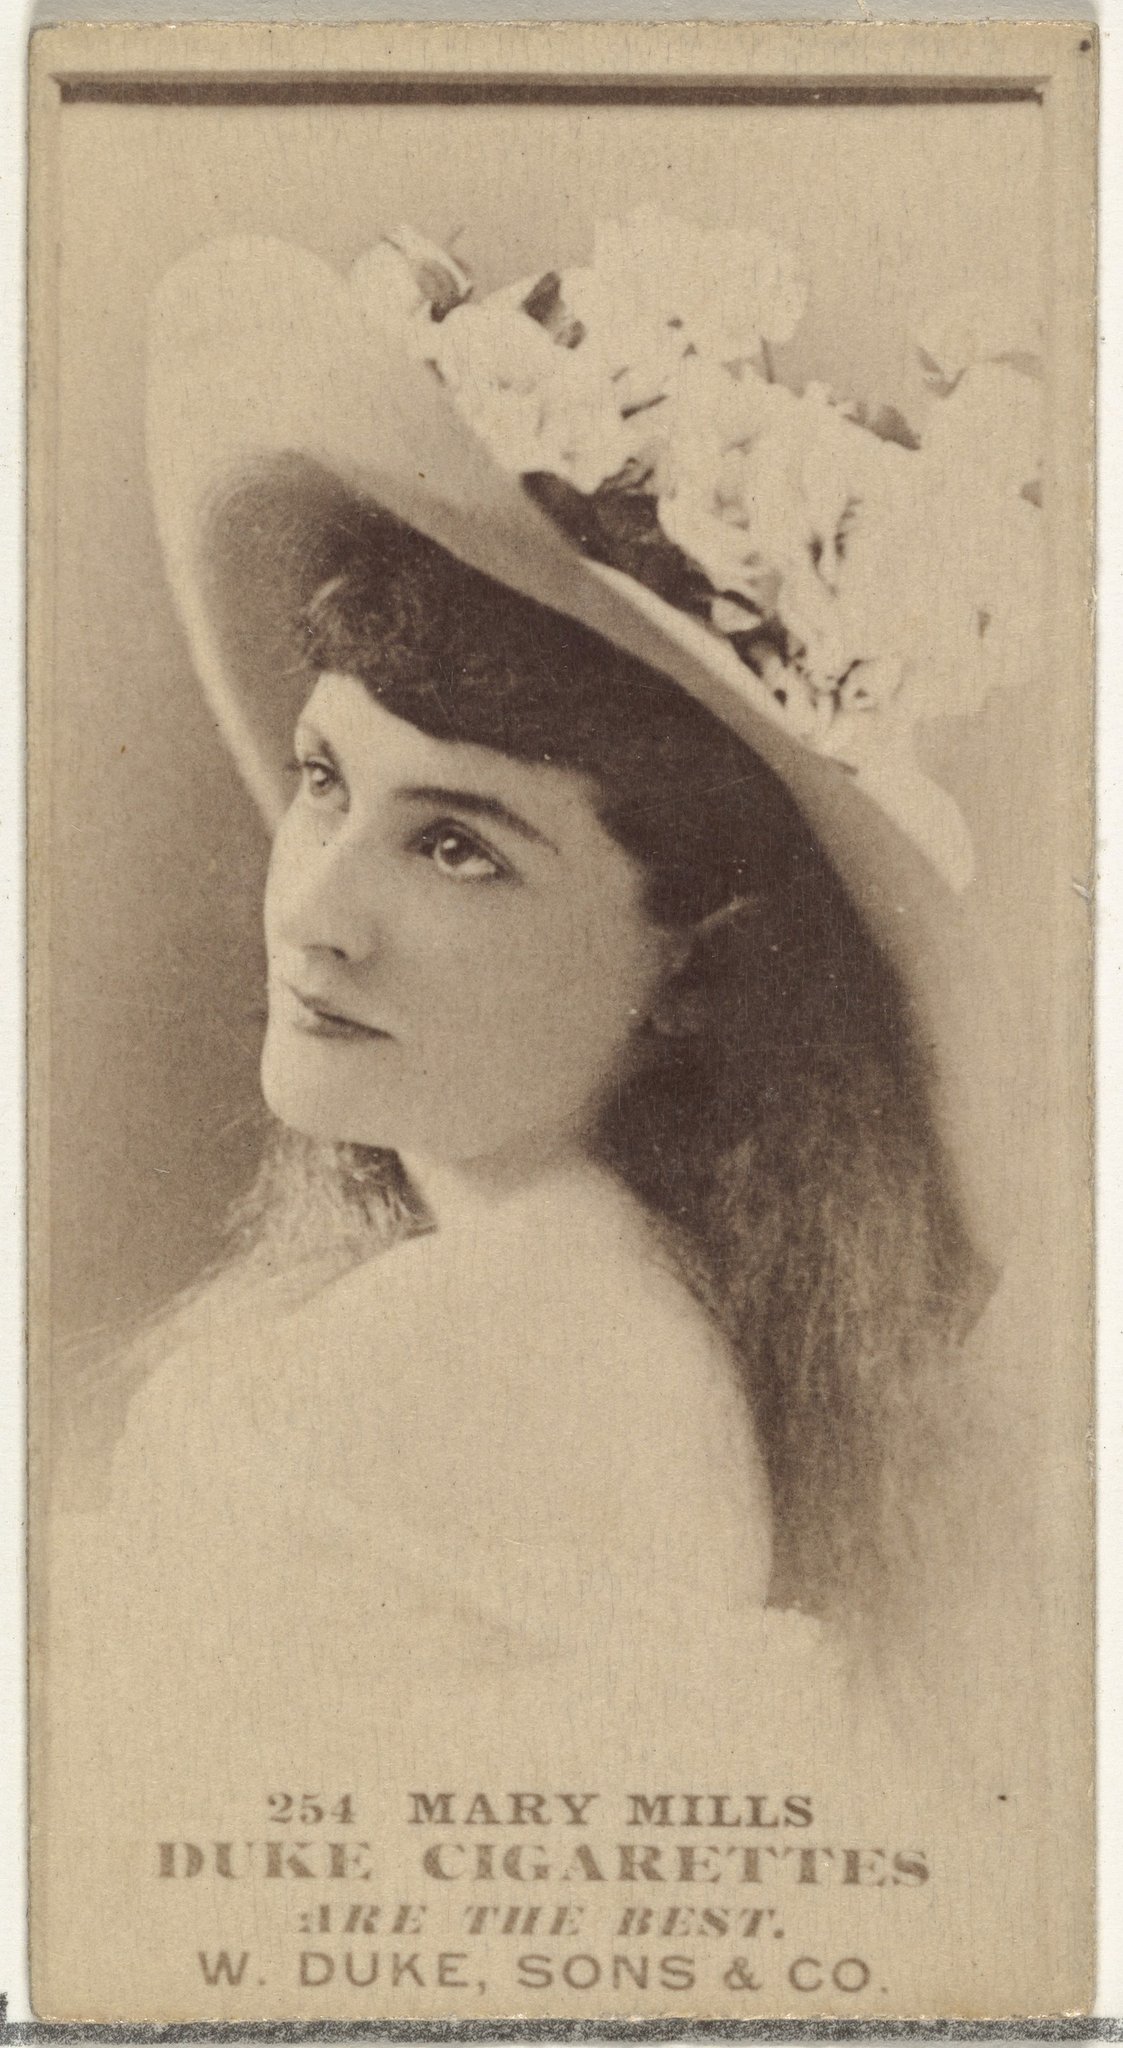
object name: photograph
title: Card Number 254, Mary Mills, from the Actors and Actresses series (N145-7) issued by Duke Sons & Co. to promote Duke Cigarettes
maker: w. duke, sons & co.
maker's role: publisher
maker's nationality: american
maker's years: 1870-1920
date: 1880-1889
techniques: albumen silver print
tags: portraits,women,actresses